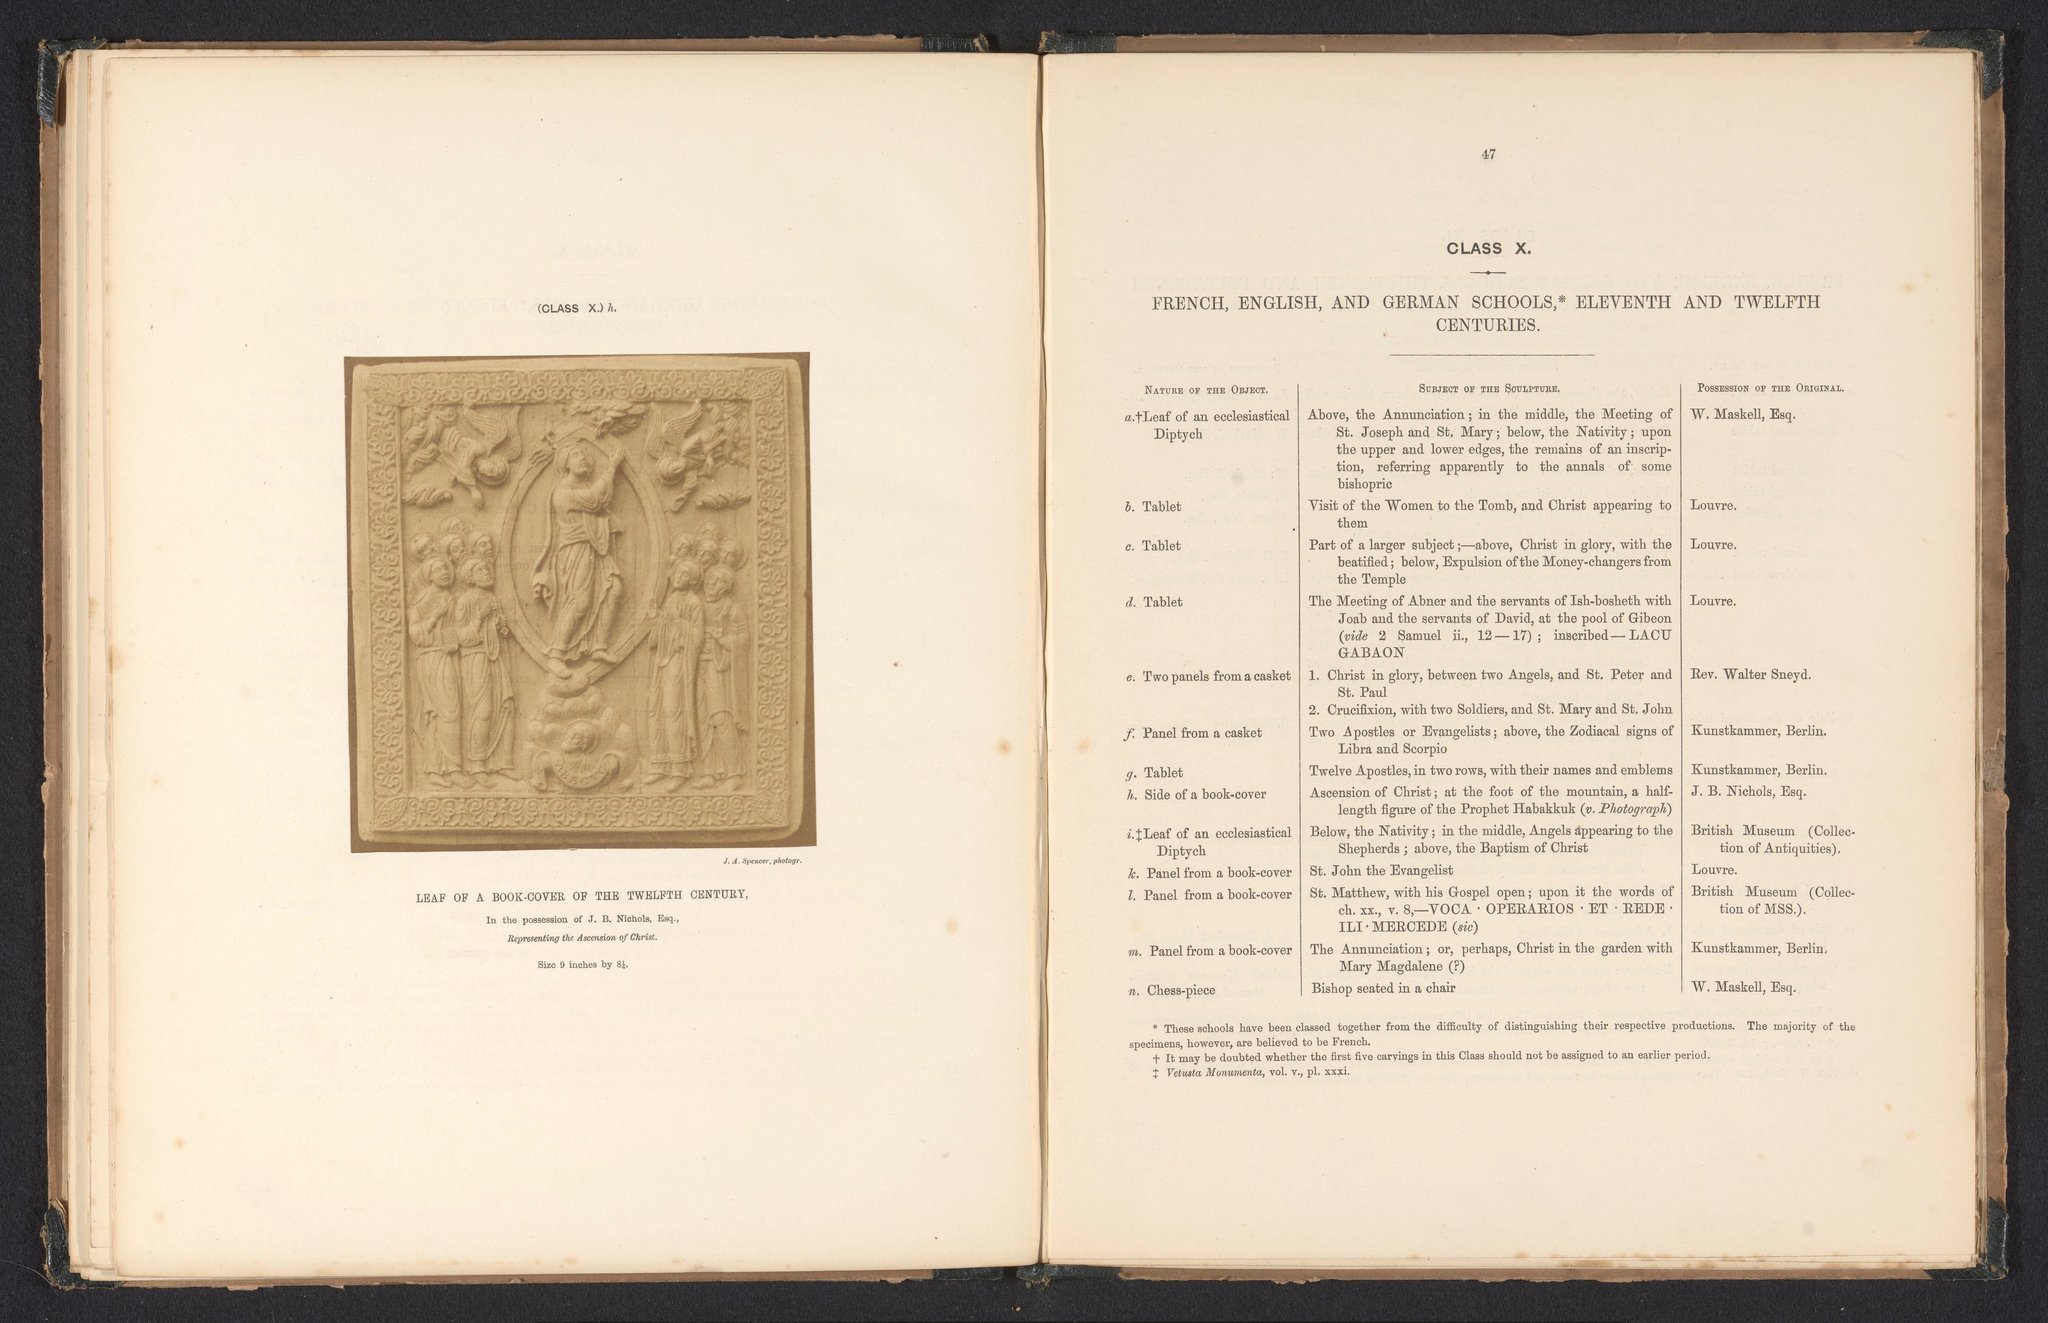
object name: photograph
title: Ivoren boekomslag, voorstellende de hemelvaart van Christus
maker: j.a. spencer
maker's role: fotograaf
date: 1850-1856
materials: photographic support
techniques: albumen print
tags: christ taken up by a cloud ~ ascension, book-cover, binding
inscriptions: inscription: ‘In the possession of J.B. Nichols, Esq., Representing the Ascension of Christ. Size 9 inches by 81/4.’, number: ‘(Class X.) h.’